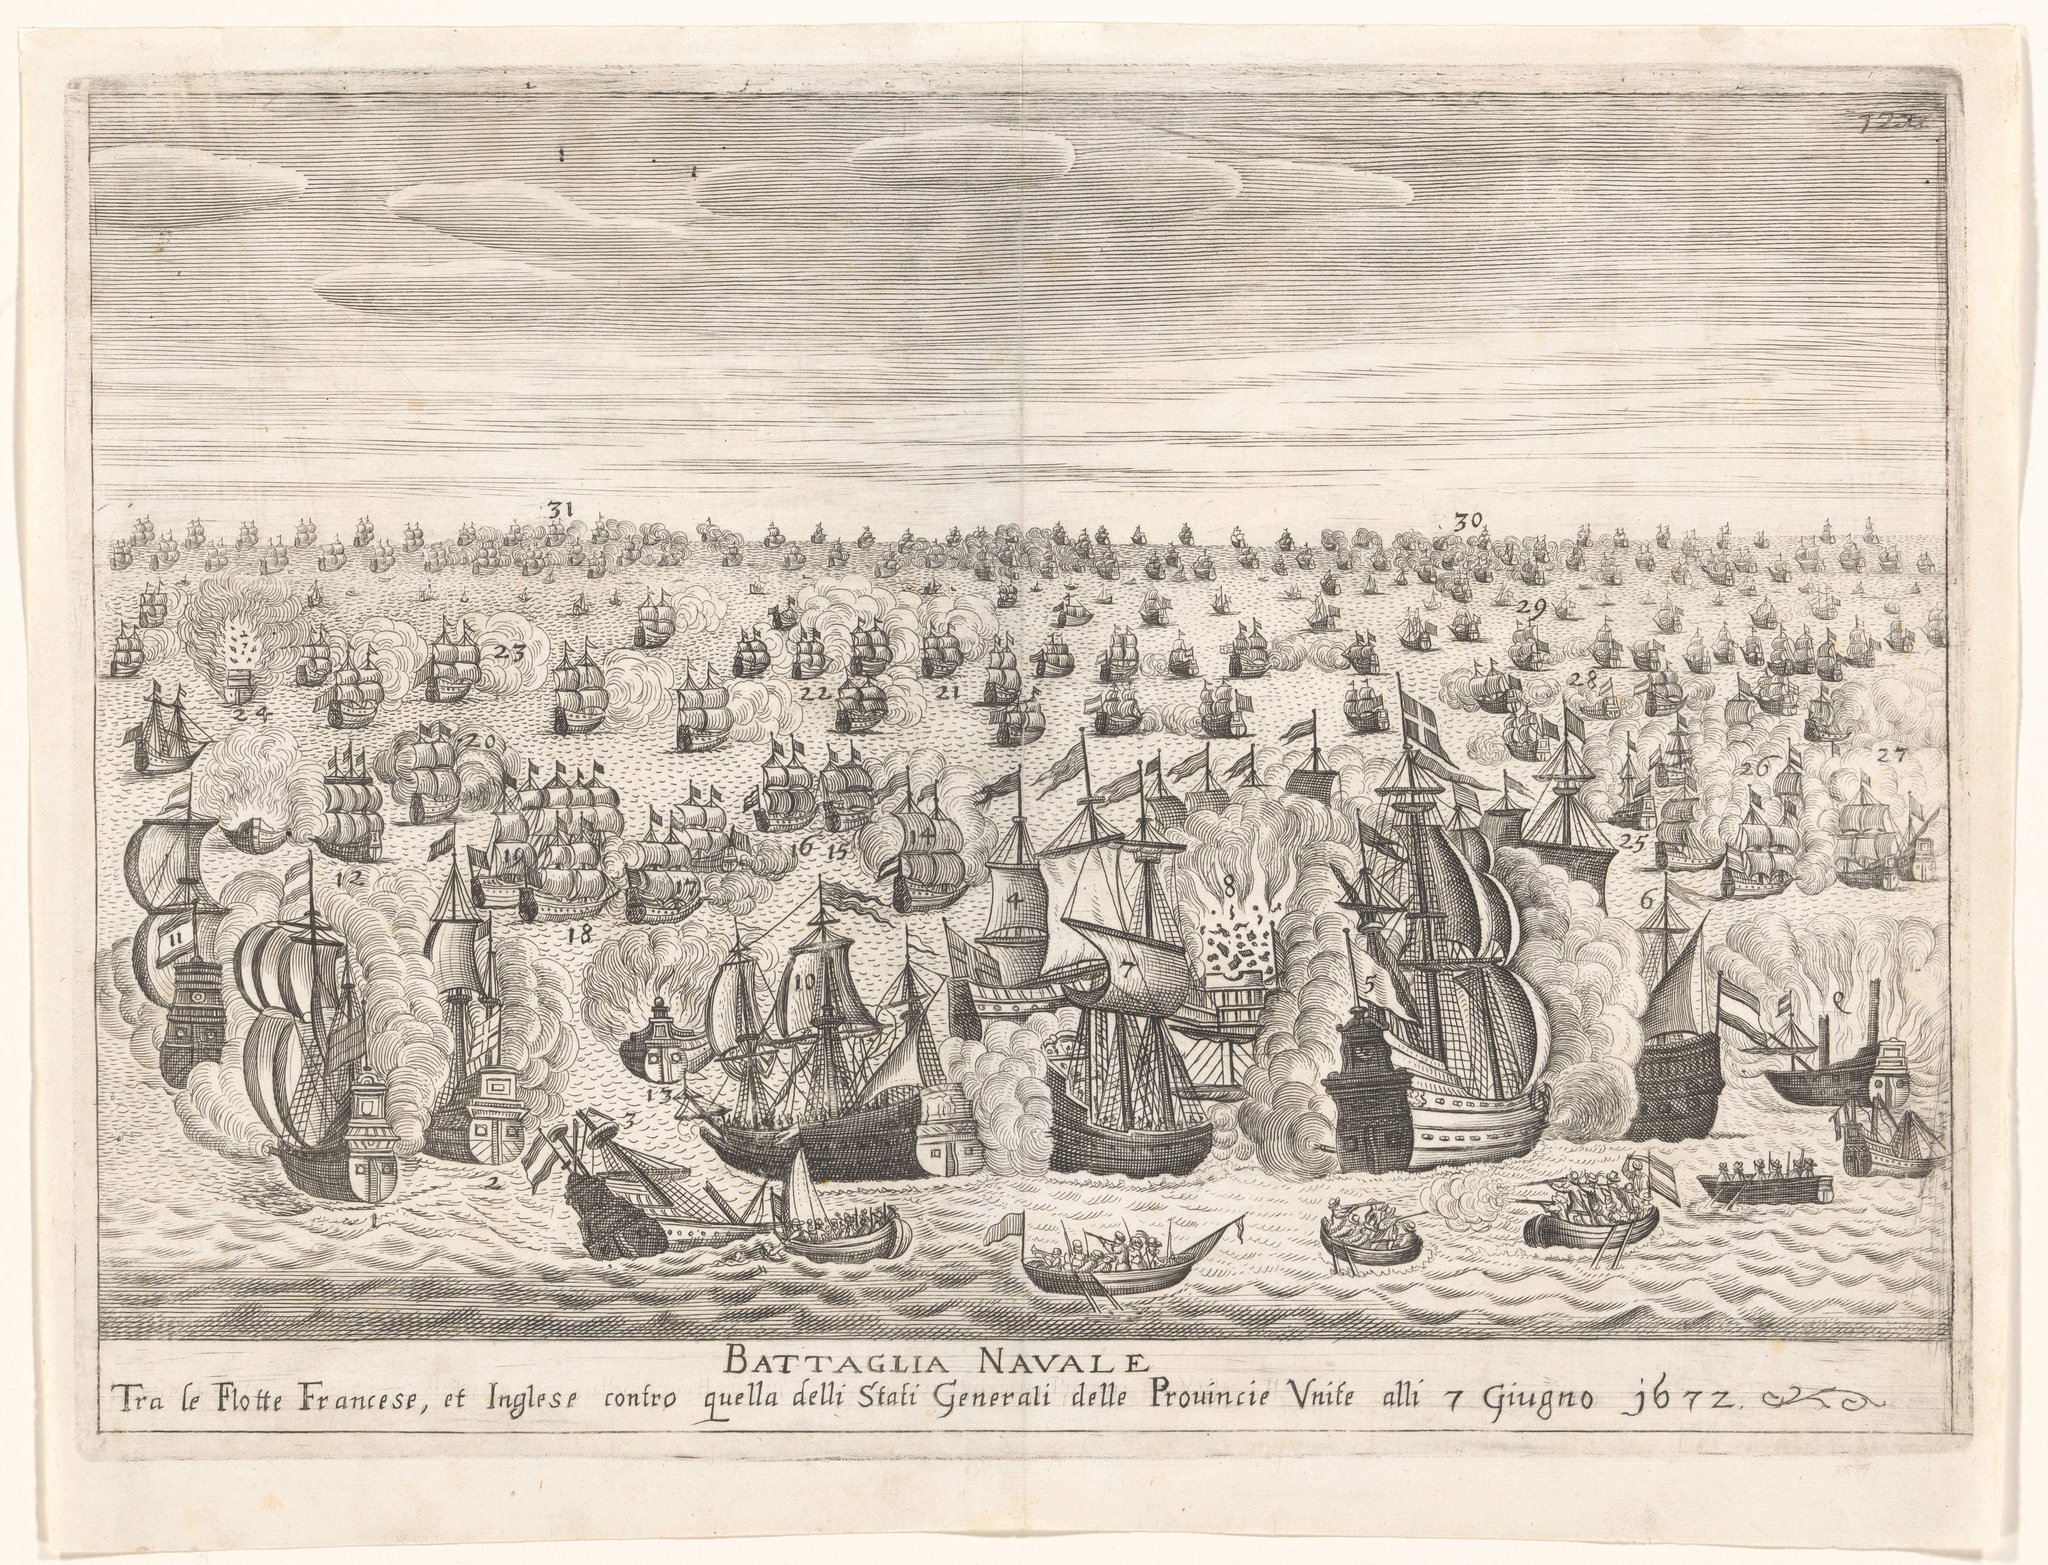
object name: print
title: Battaglia Navale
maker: Anonymous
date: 1673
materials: paper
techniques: engraving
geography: netherlands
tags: sailing-ship, sailing-boat, battle (+ sailing-ships), battle of solebay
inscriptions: inscription: ‘BATTAGLIA NAVALE tra le flotte Francese, et Inglese contro quella delli Stati Generali delle Provincie Unite alli 7 Giugno 1672’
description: De prent is verschenen in: Galeazzo Gualdo Priorato, 'Teatro del Belgio' (Frankfort 1673). Dit boek bevindt zich anno 2018 niet in de collectie van het Rijksmuseum.